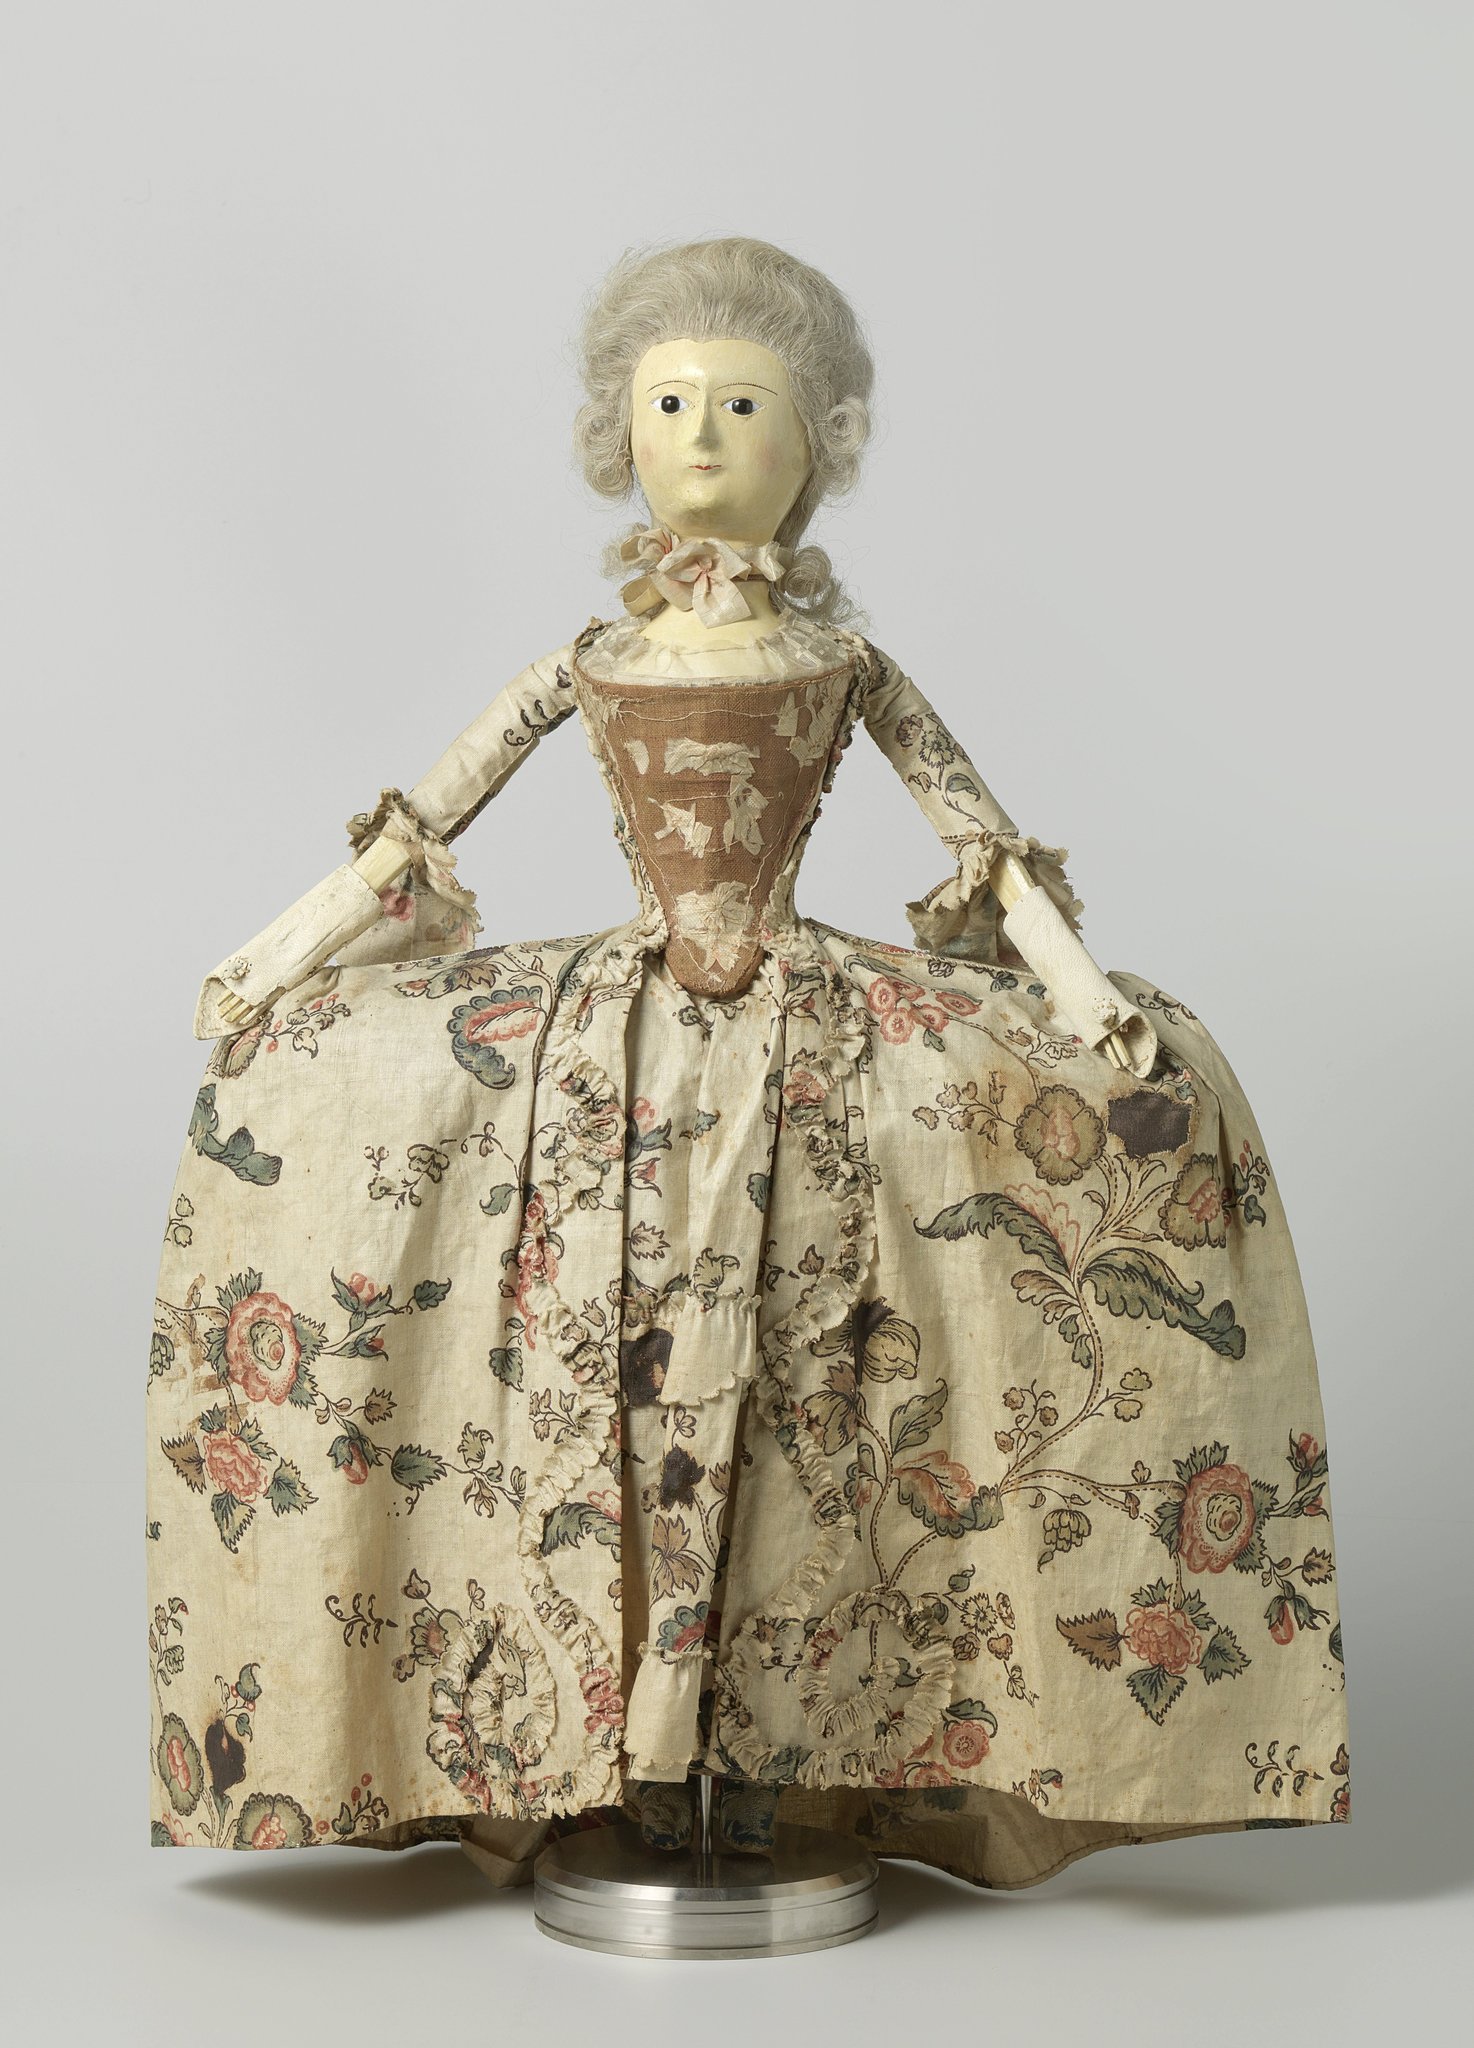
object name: doll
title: Pop van hout met glazen ogen en kapsel van mensenhaar, gekleed in een japon (demi-parure) van gebloemde sits, bestaande uit een overjapon en een tablier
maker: Anonymous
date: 1760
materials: textile, cotton, glass, leather, gypsum, hair, linen, oil, silk, wood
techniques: brocade, knitting, painting, painted, quilting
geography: france